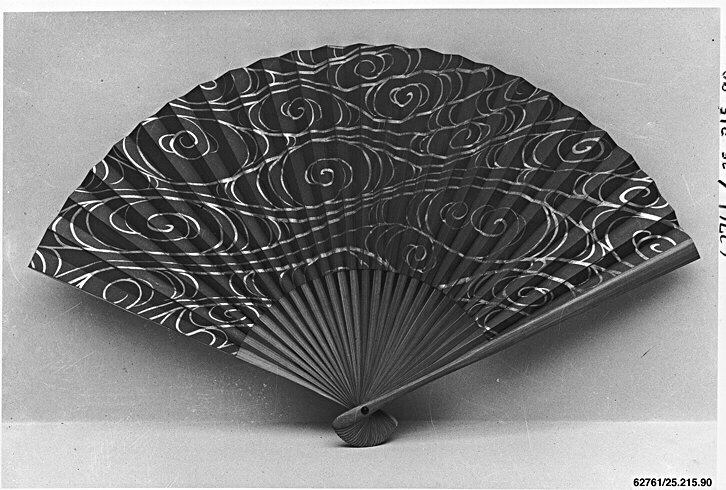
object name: folding fan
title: Fan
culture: japanese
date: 1901-2000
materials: metal, paint, paper